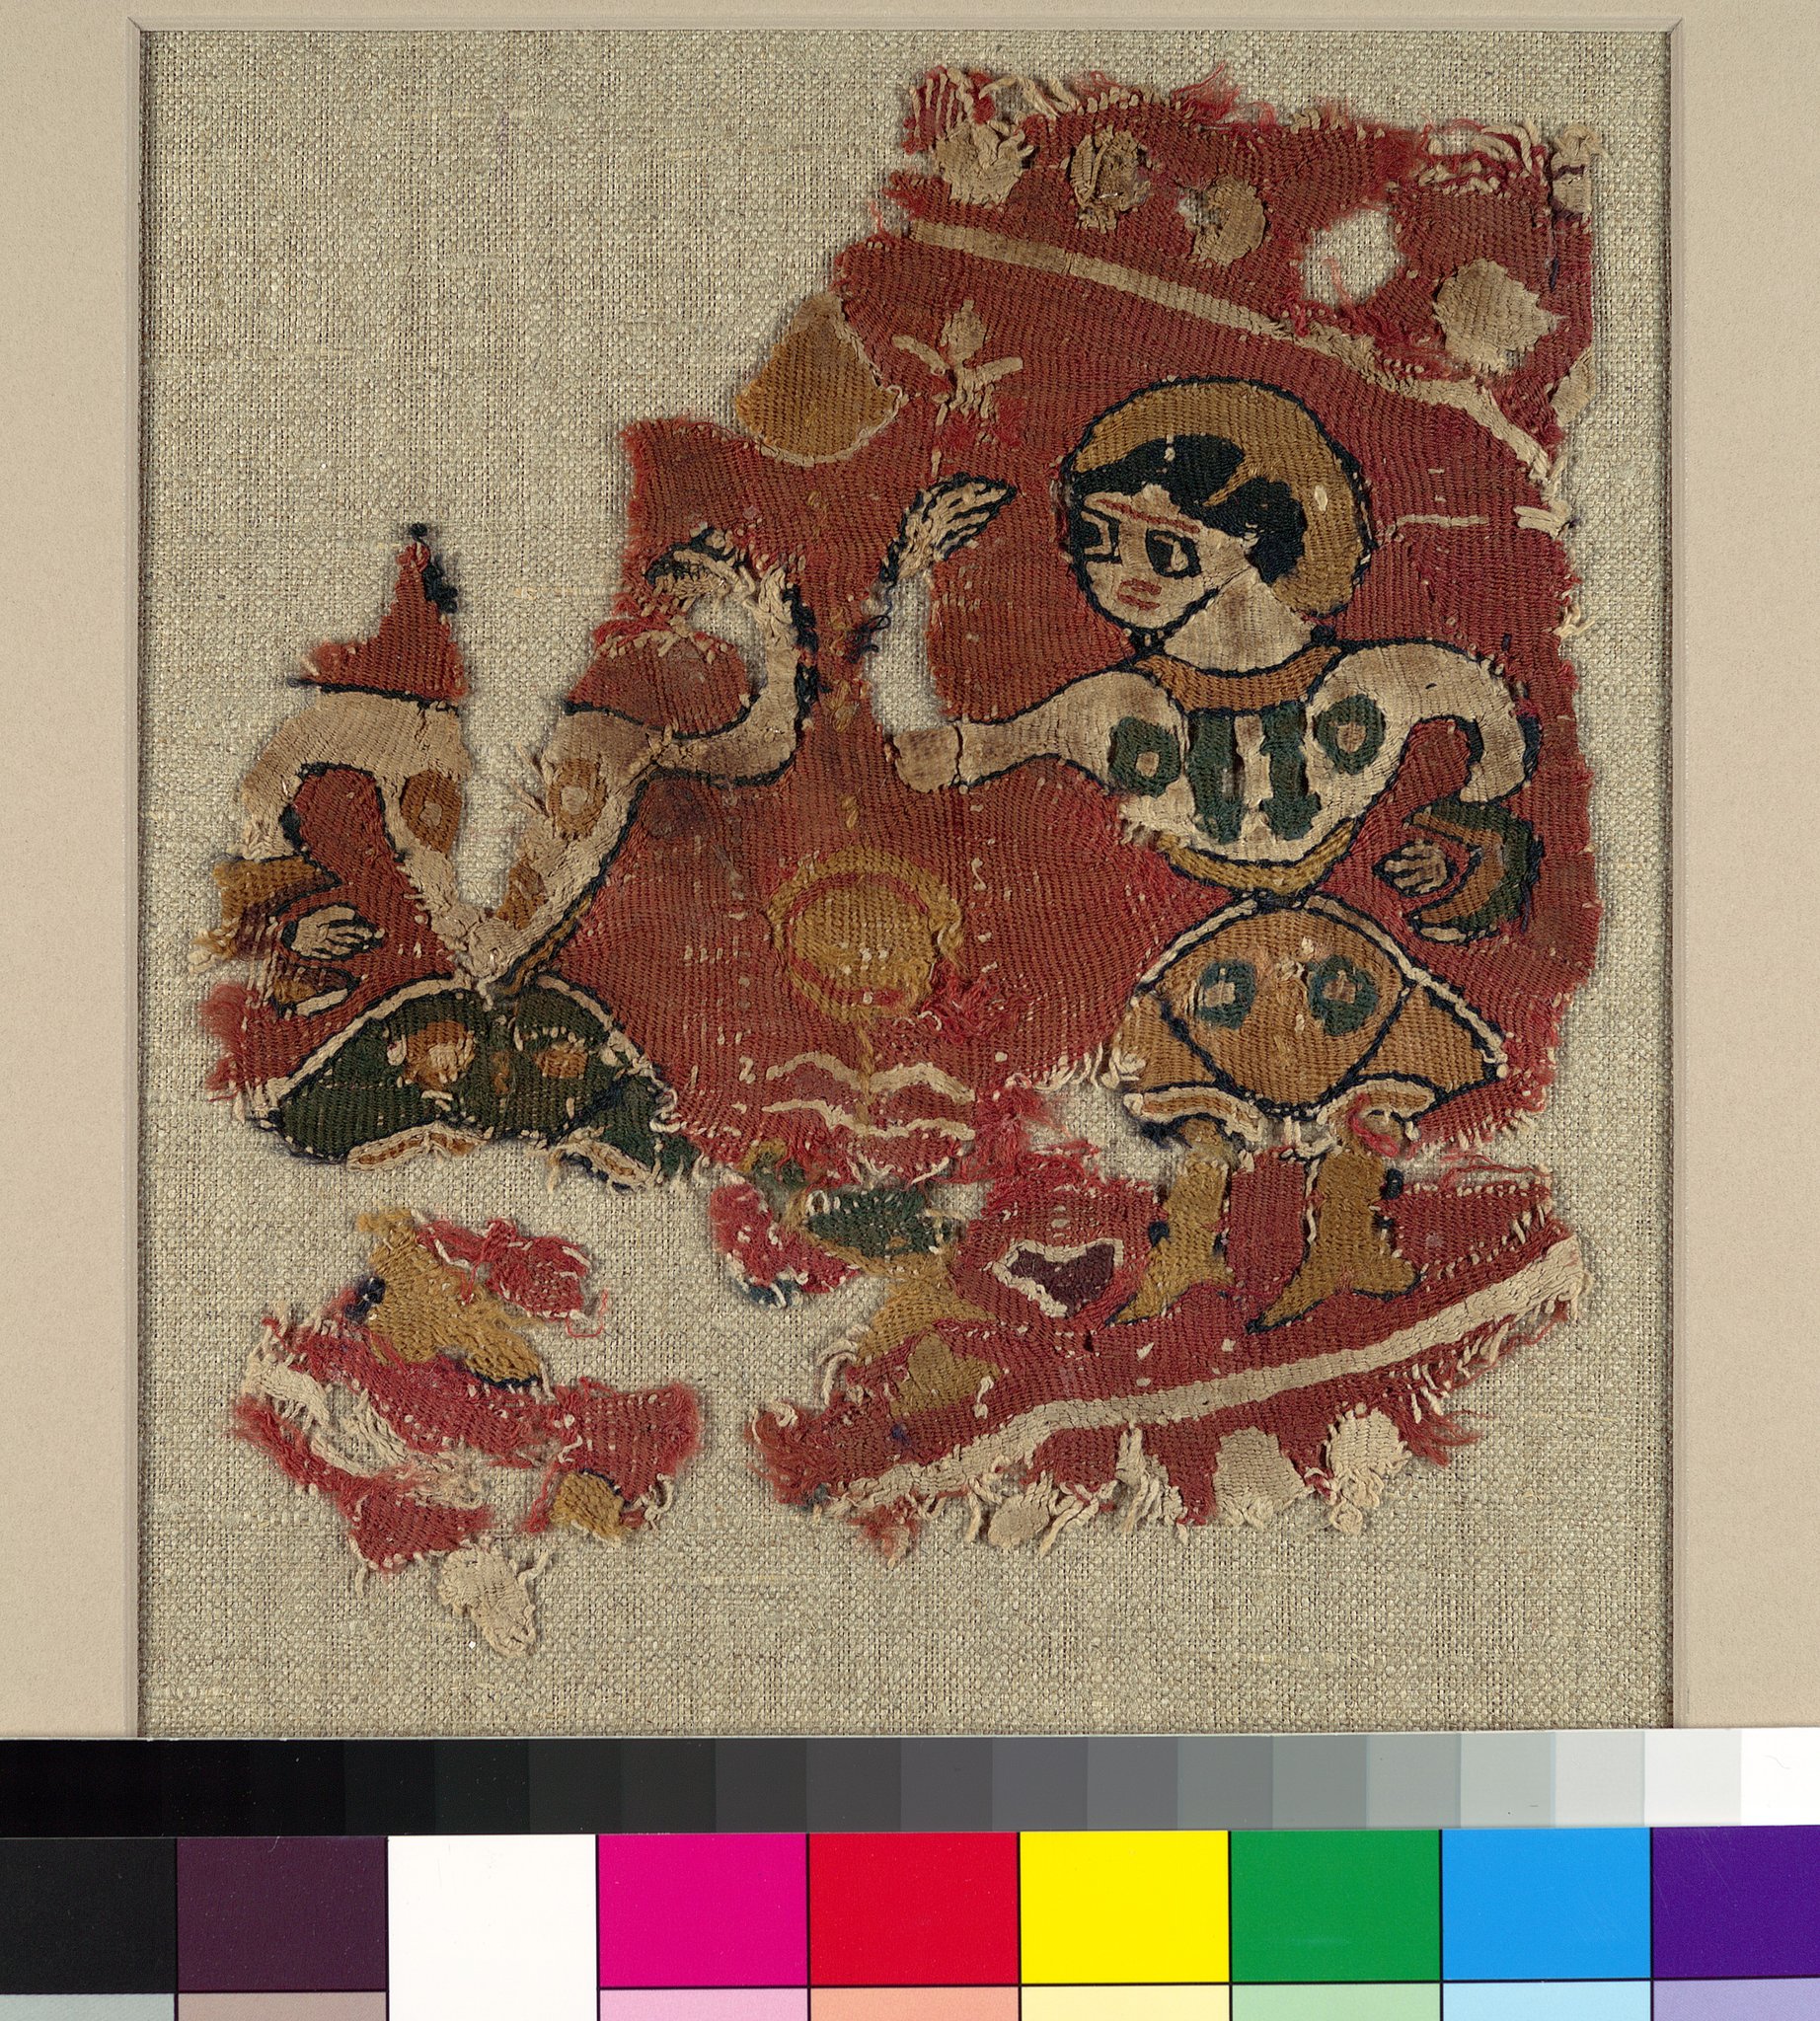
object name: textile fragment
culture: byzantine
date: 601-800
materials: linen, wool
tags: human figures